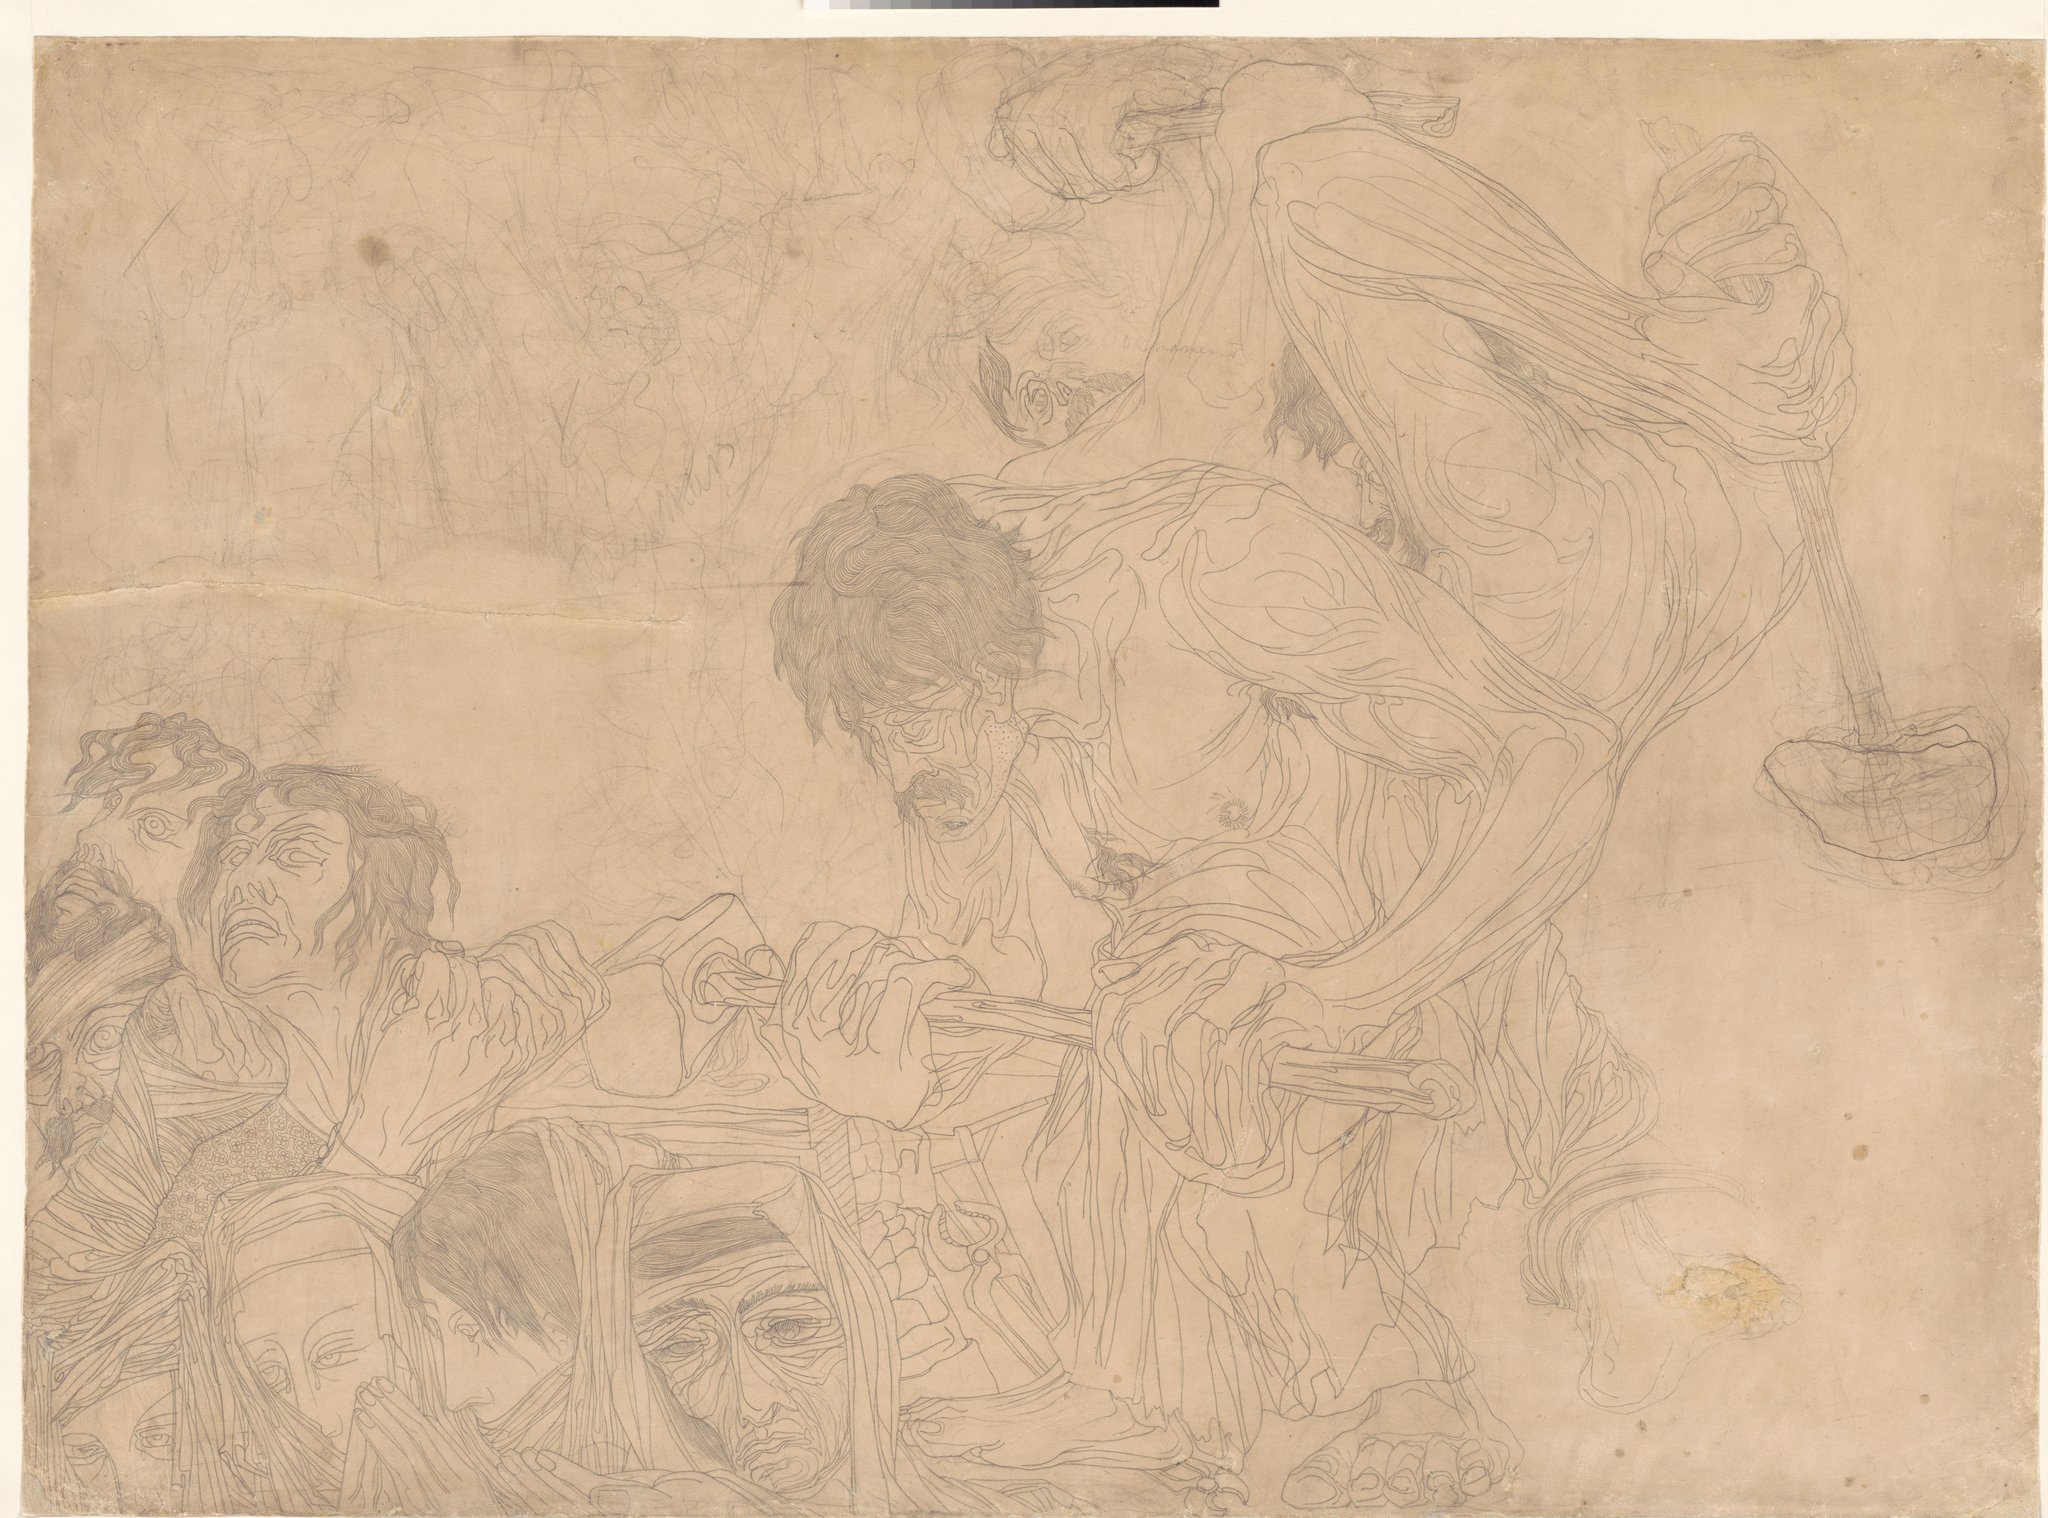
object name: drawing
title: De smid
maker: johan thorn prikker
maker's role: draughtsman, print maker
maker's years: 1868-1932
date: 1869-1932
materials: chalk, paper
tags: smith, blacksmith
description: Le Forgeron, naar het gedicht van Verhaeren (?).